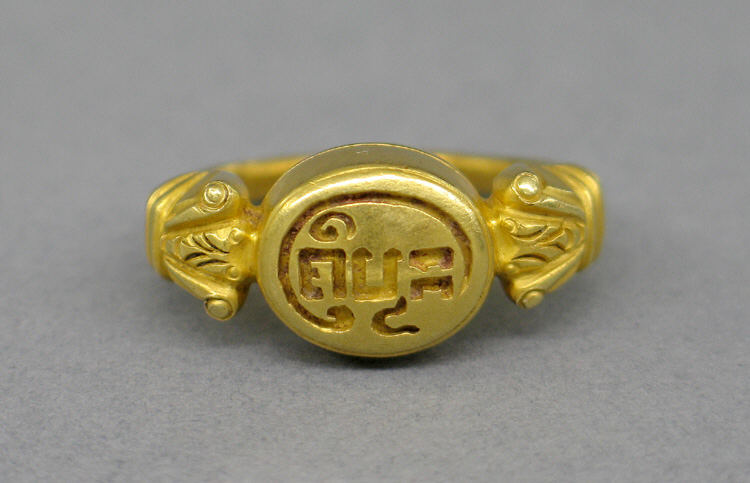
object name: ring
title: Stirrup-shaped Ring with Oval Bezel and "Java Kuno"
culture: indonesian, javanese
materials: gold